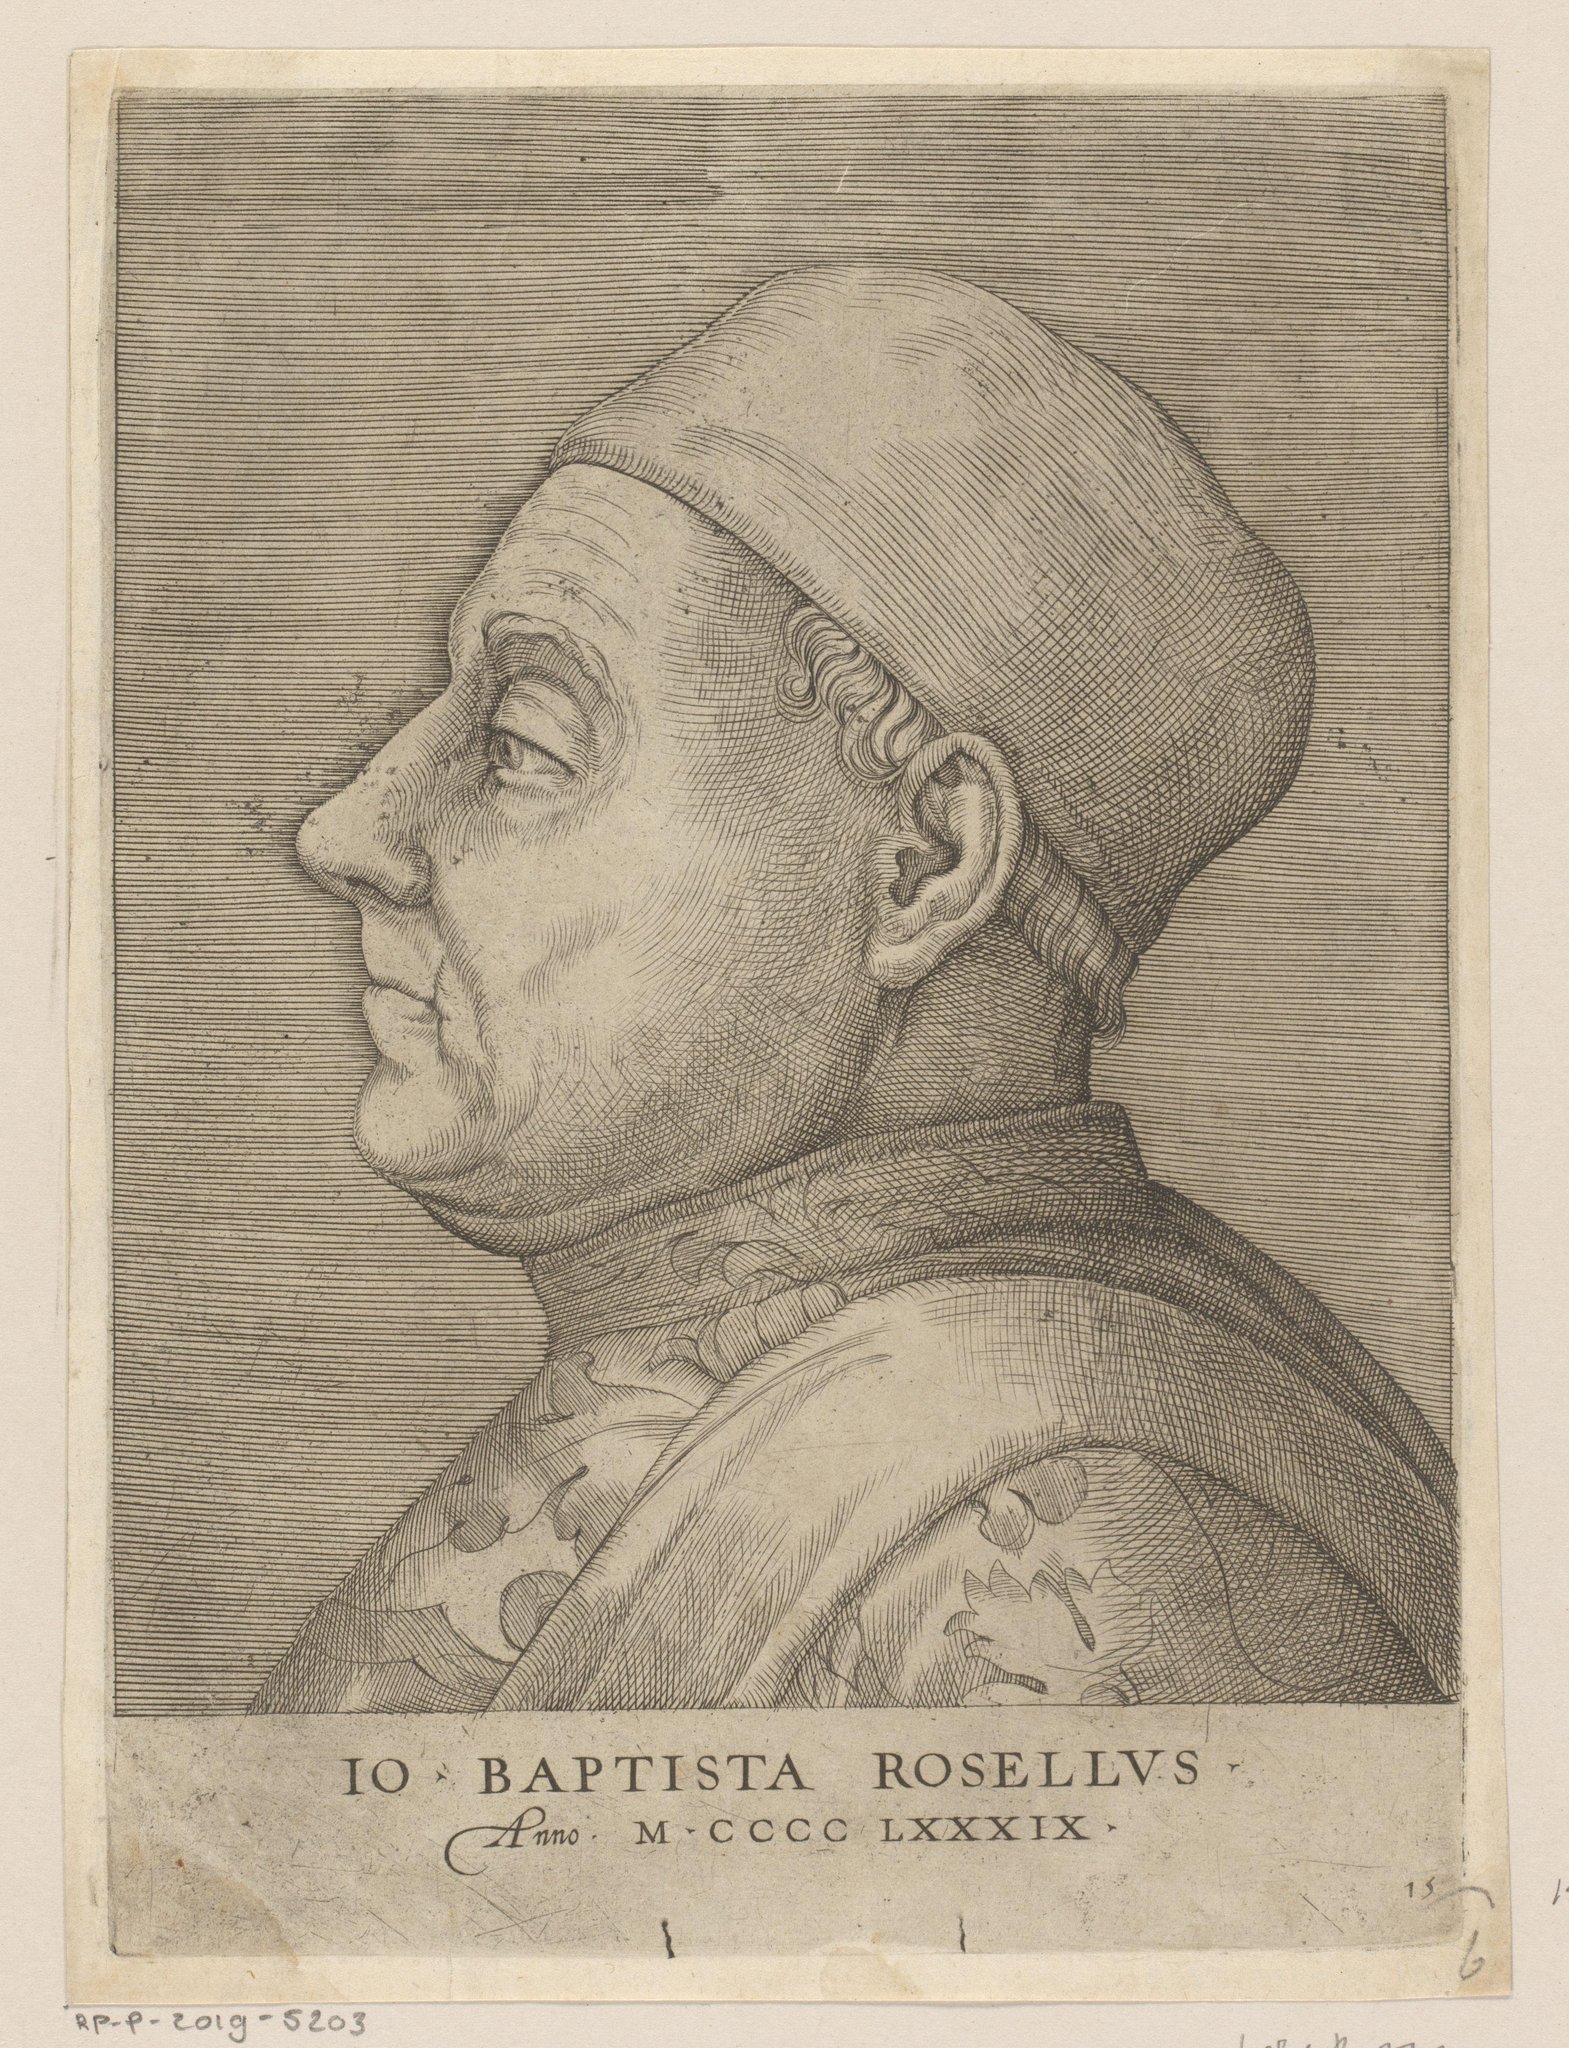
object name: print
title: Portretten van nobele juristen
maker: Anonymous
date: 1566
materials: paper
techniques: engraving, intaglio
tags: historical persons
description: Prentserie voor het eerst uitgegeven te Rome door Antonio Lafreri in 1566. Serie waarschijnlijk opnieuw uitgegeven door Petri de' Nobili rond 1584-1585.